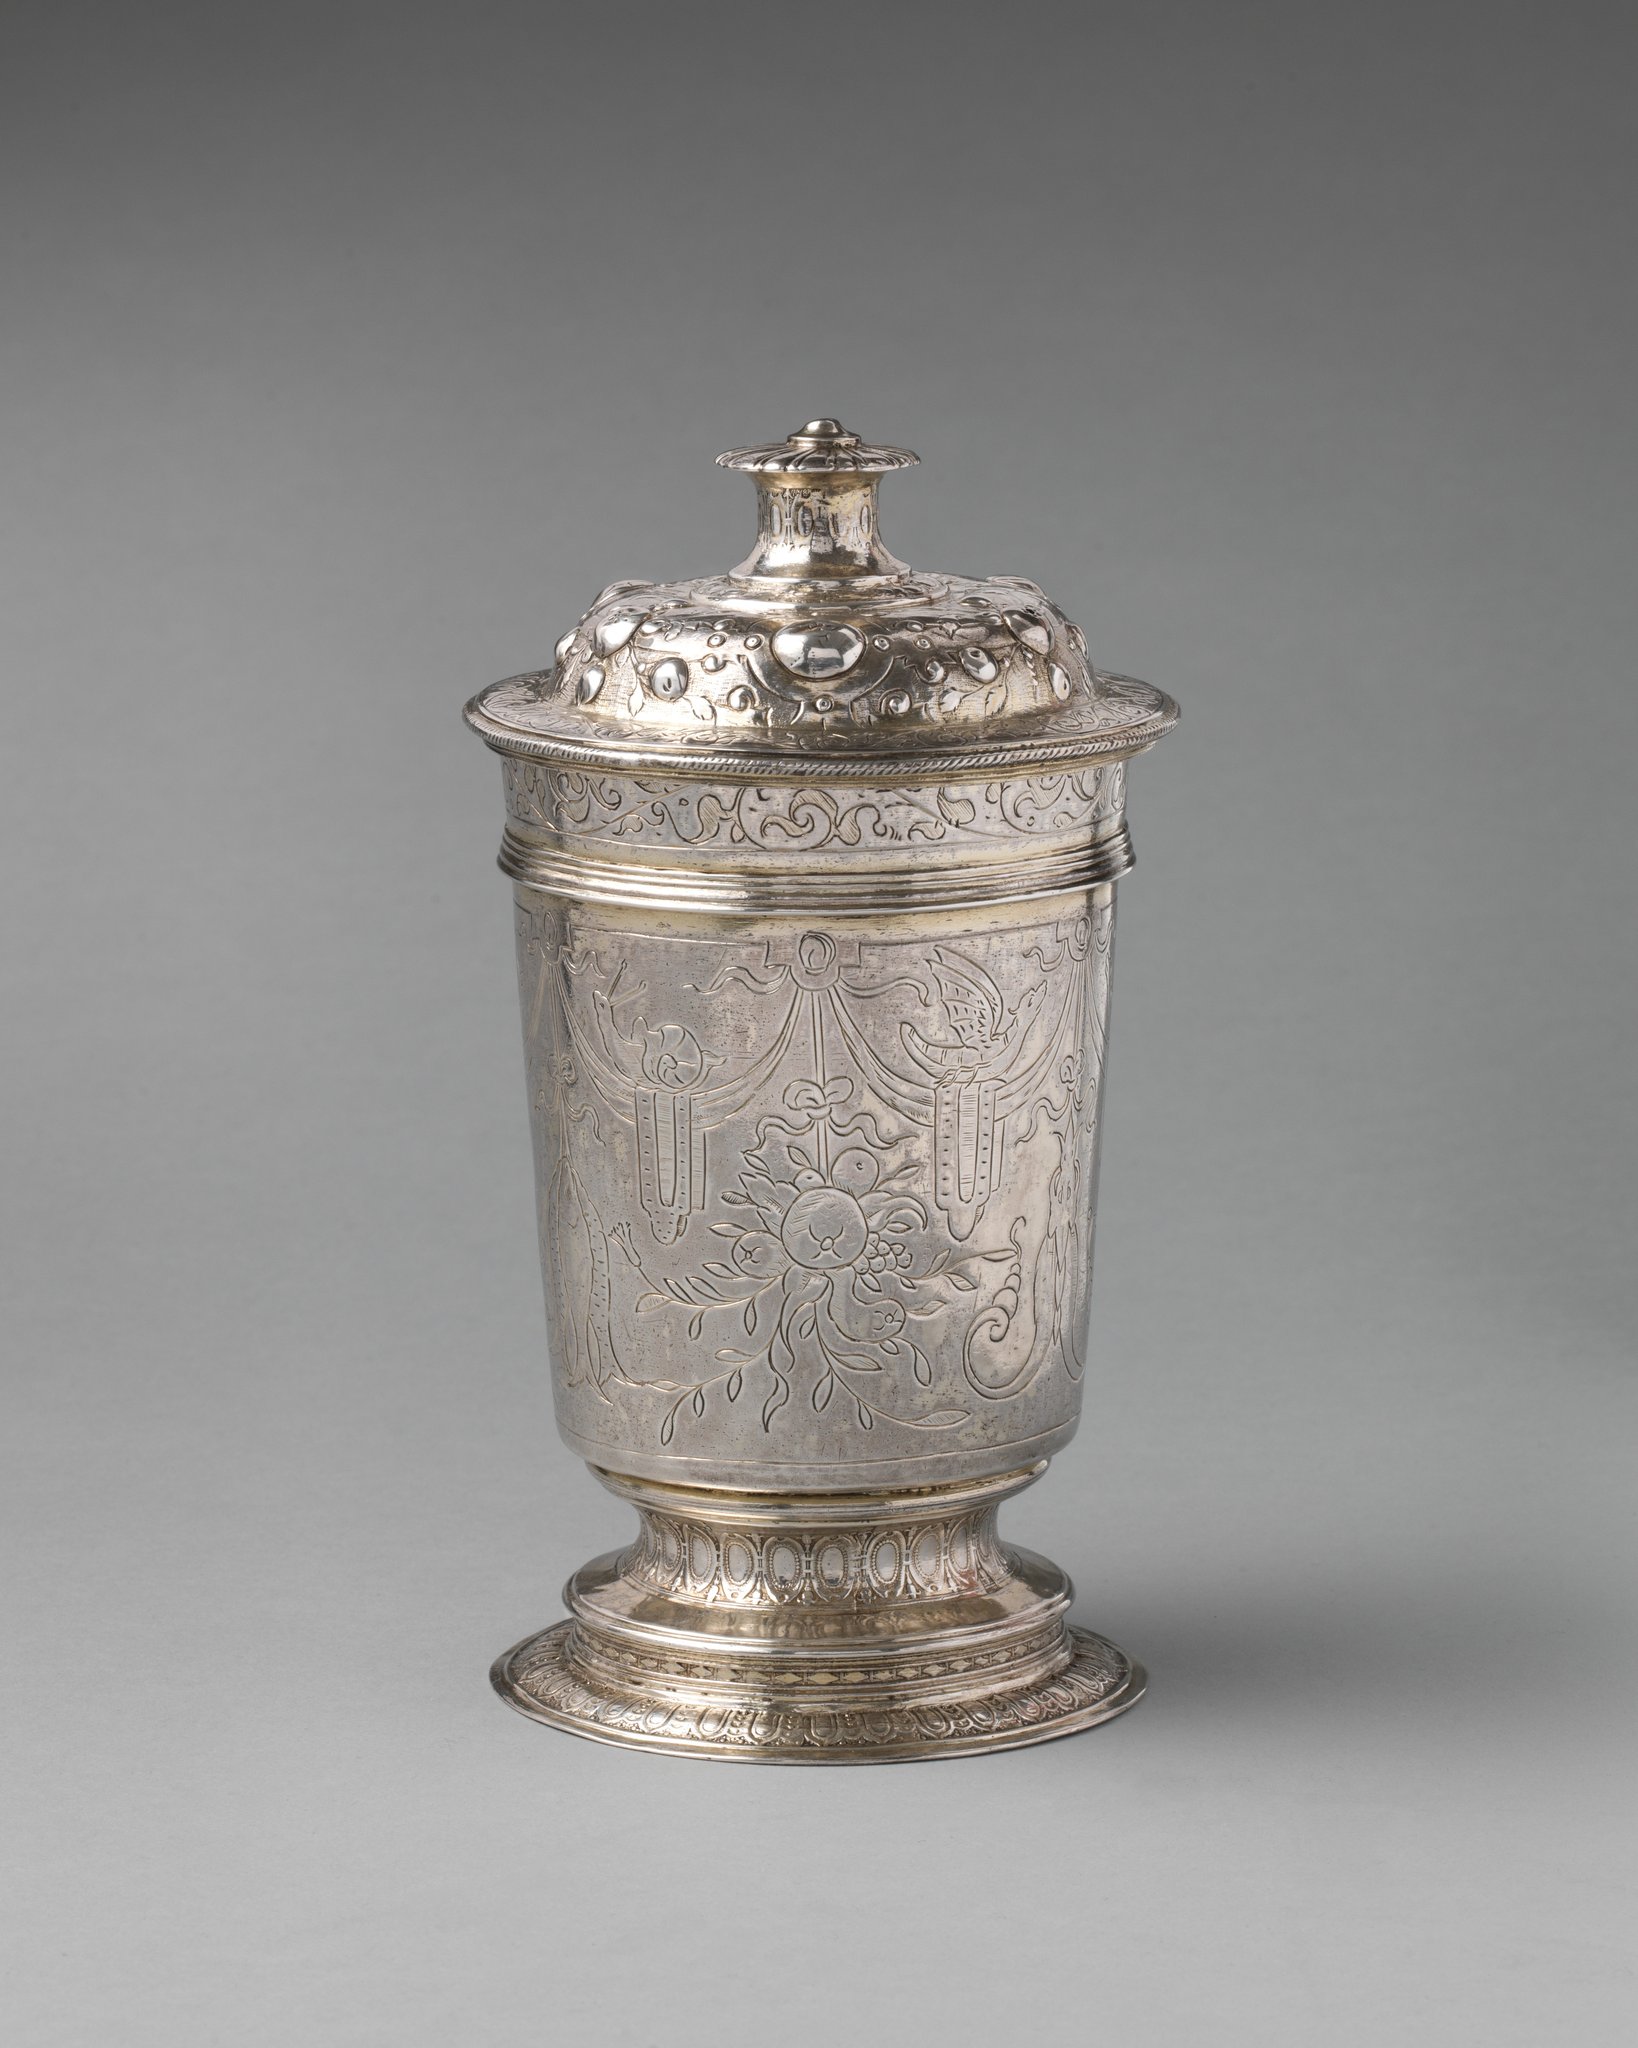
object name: cup with cover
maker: m., london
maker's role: maker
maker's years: 1581-1586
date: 1581-1582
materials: silver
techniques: gilding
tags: fruit,fish,snails